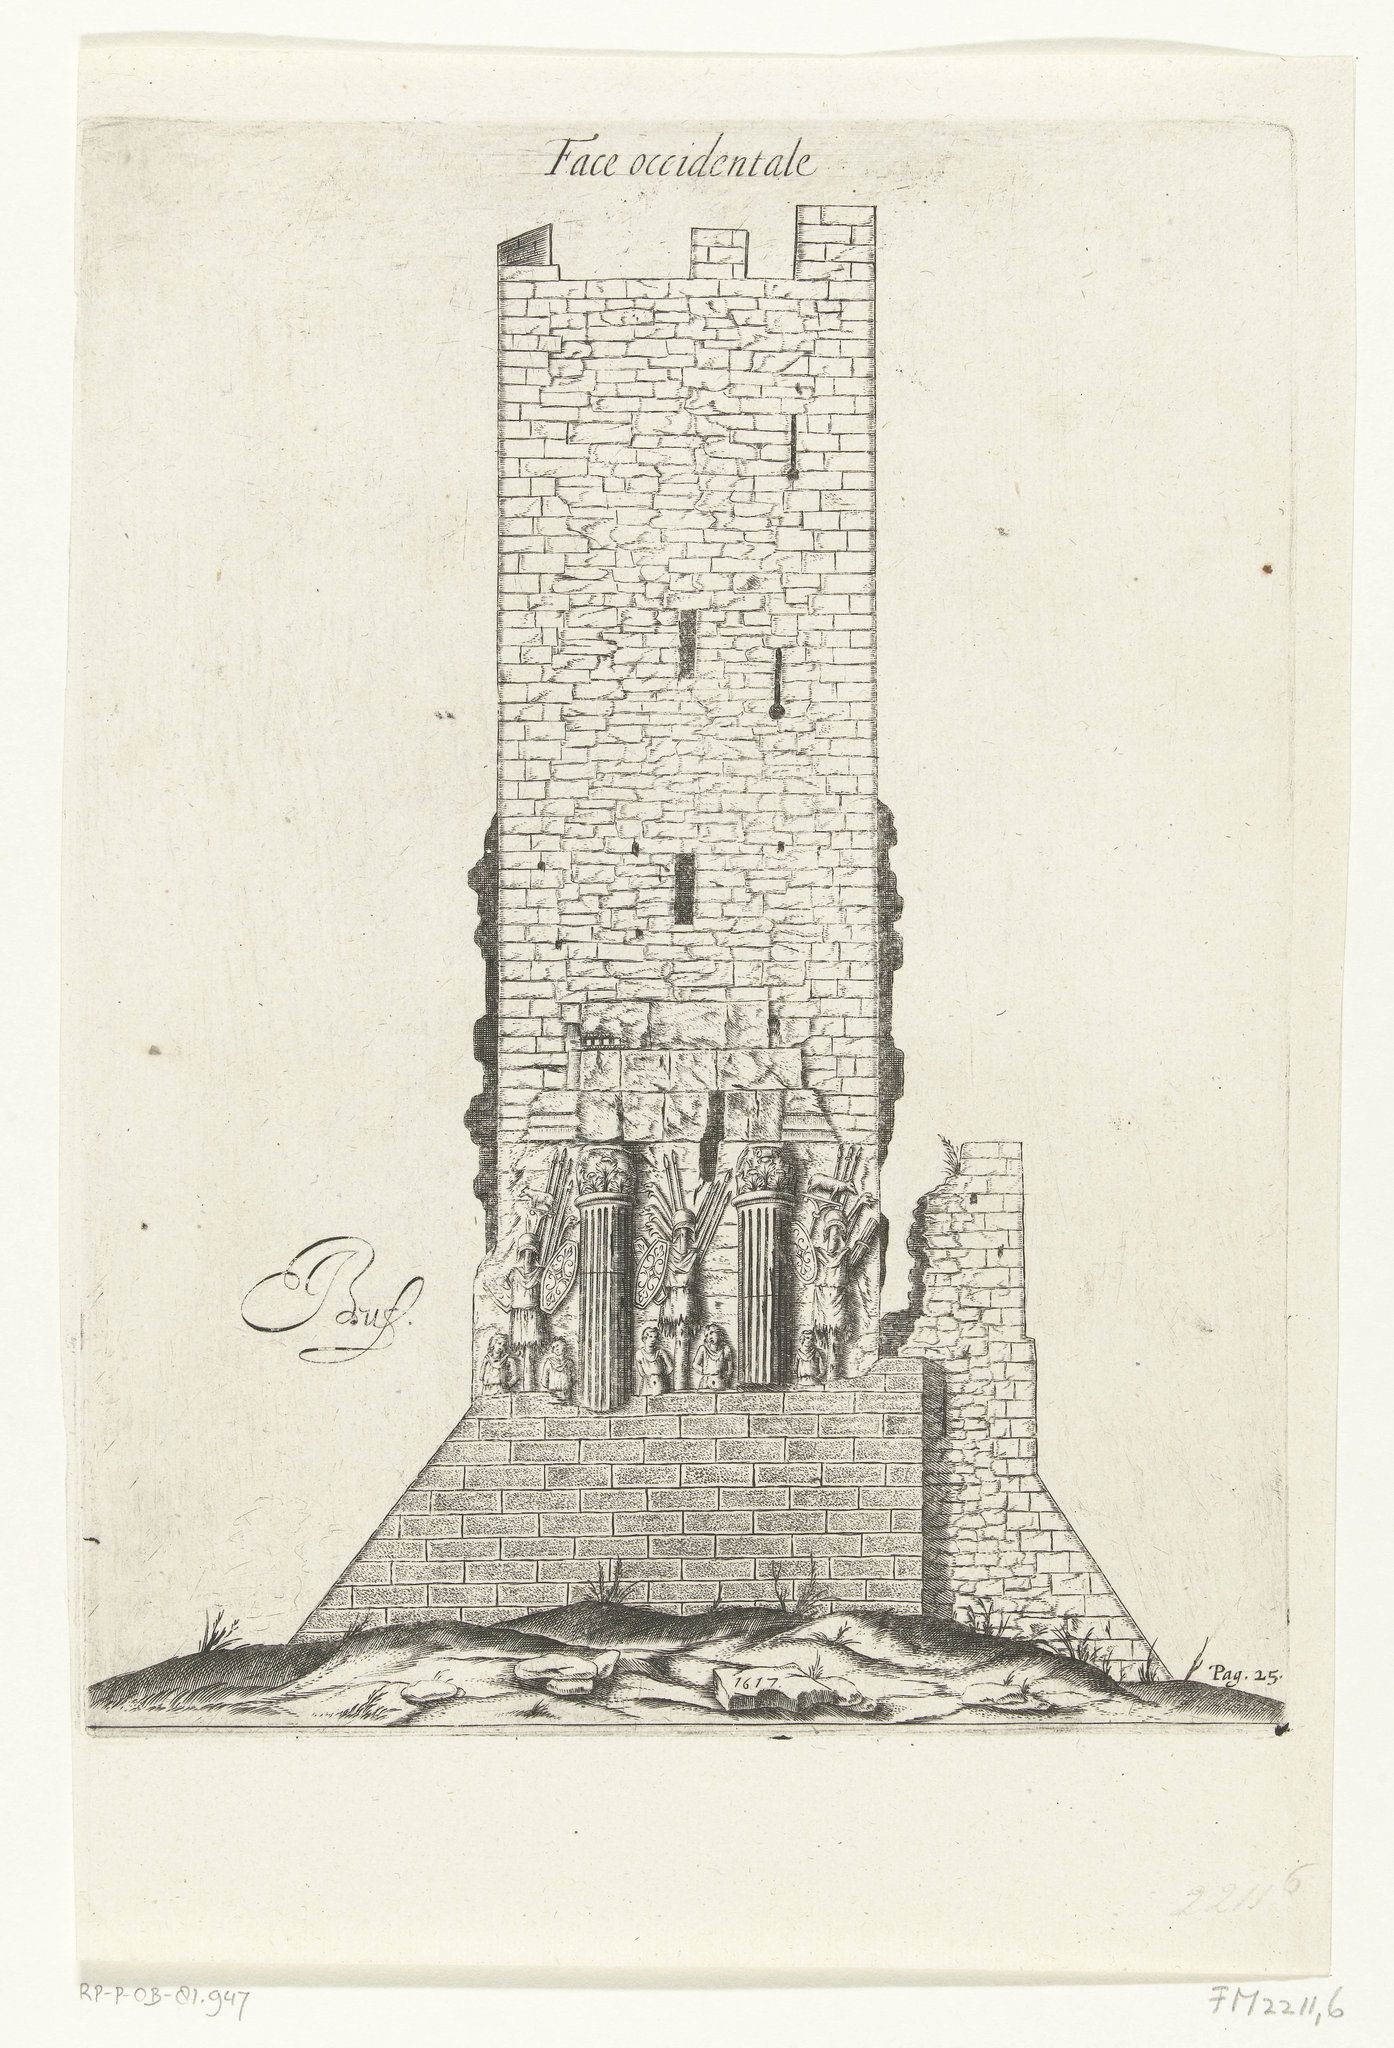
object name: print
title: Romeinse triomfboog in Orange, 1639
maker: jean beuf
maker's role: print maker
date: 1637-1640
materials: paper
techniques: engraving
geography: france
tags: triumphal arch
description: Gebruikt als illustratie in: Joseph de la Pisé, Tableau de l'histoire des princes et principauté d'Orange, Den Haag, 1639-1640, p. 25.